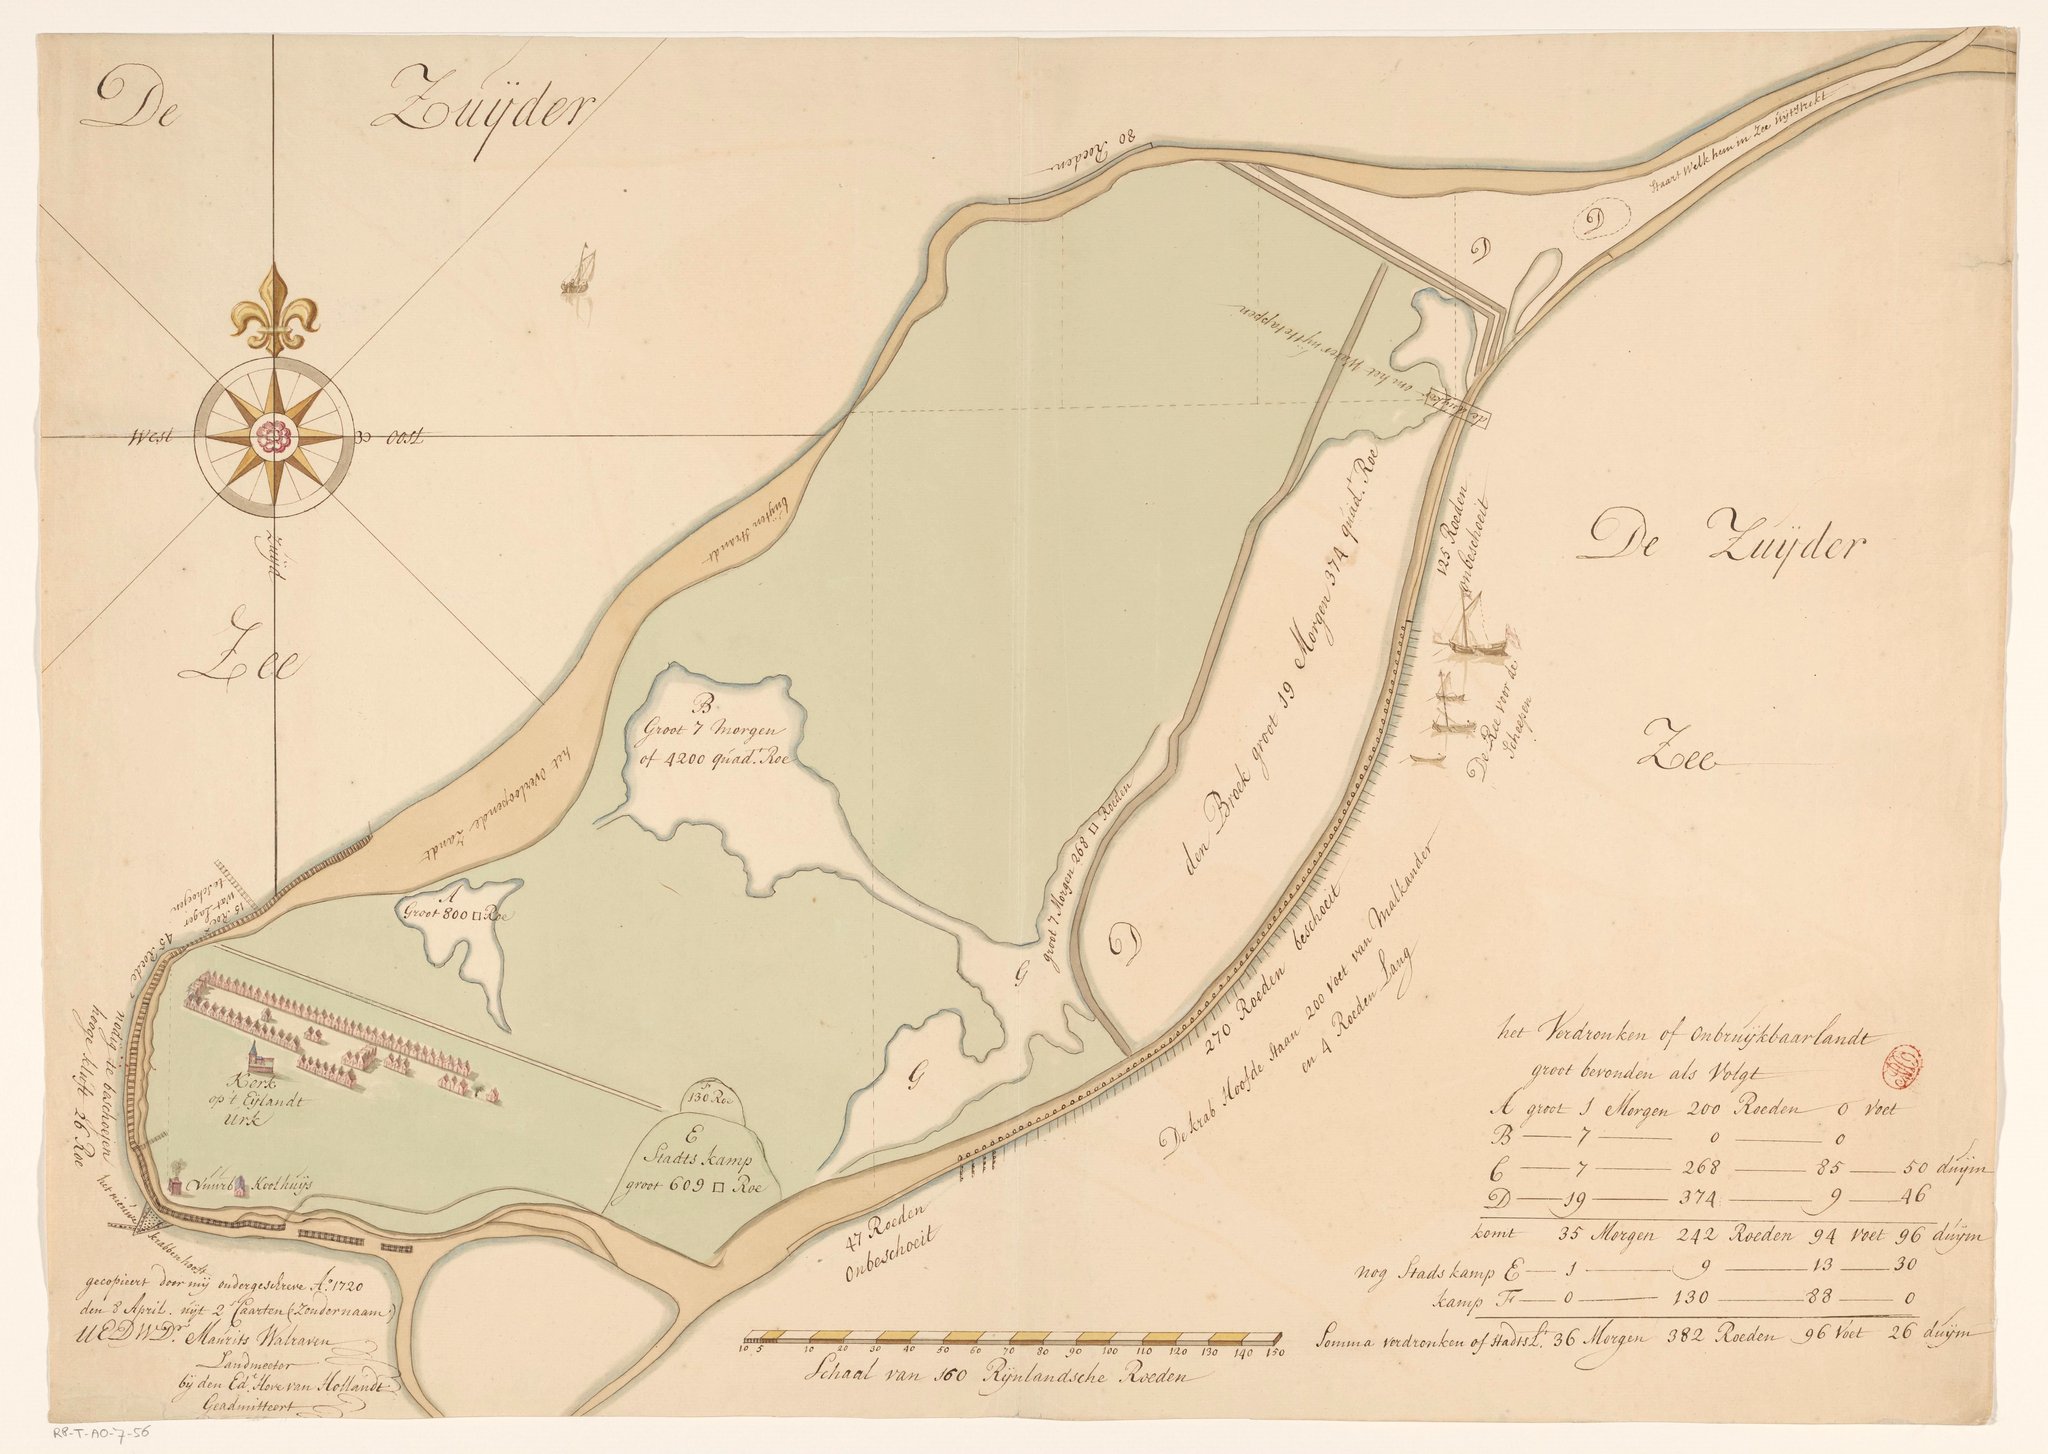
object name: drawing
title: Kaart van het eiland Urk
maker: maurits walraven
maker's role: draughtsman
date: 1720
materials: ink, paper, watercolor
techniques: brush, pen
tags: maps of separate countries or regions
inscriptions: collector's mark: Lugt 2228, collector's mark: Lugt 195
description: Manuscriptkaart van het eiland Urk, in 1720 getekend door landmeter Maurits Walraven aan de hand van twee anonieme kaarten. Onderaan in het midden een schaalstok: Schaal van 160 Rijnlandsche roeden. Rechtsonder een legenda en informatie over verdronken stukken land op het eiland, die met de letters A t/m F staan aangegeven op de kaart.